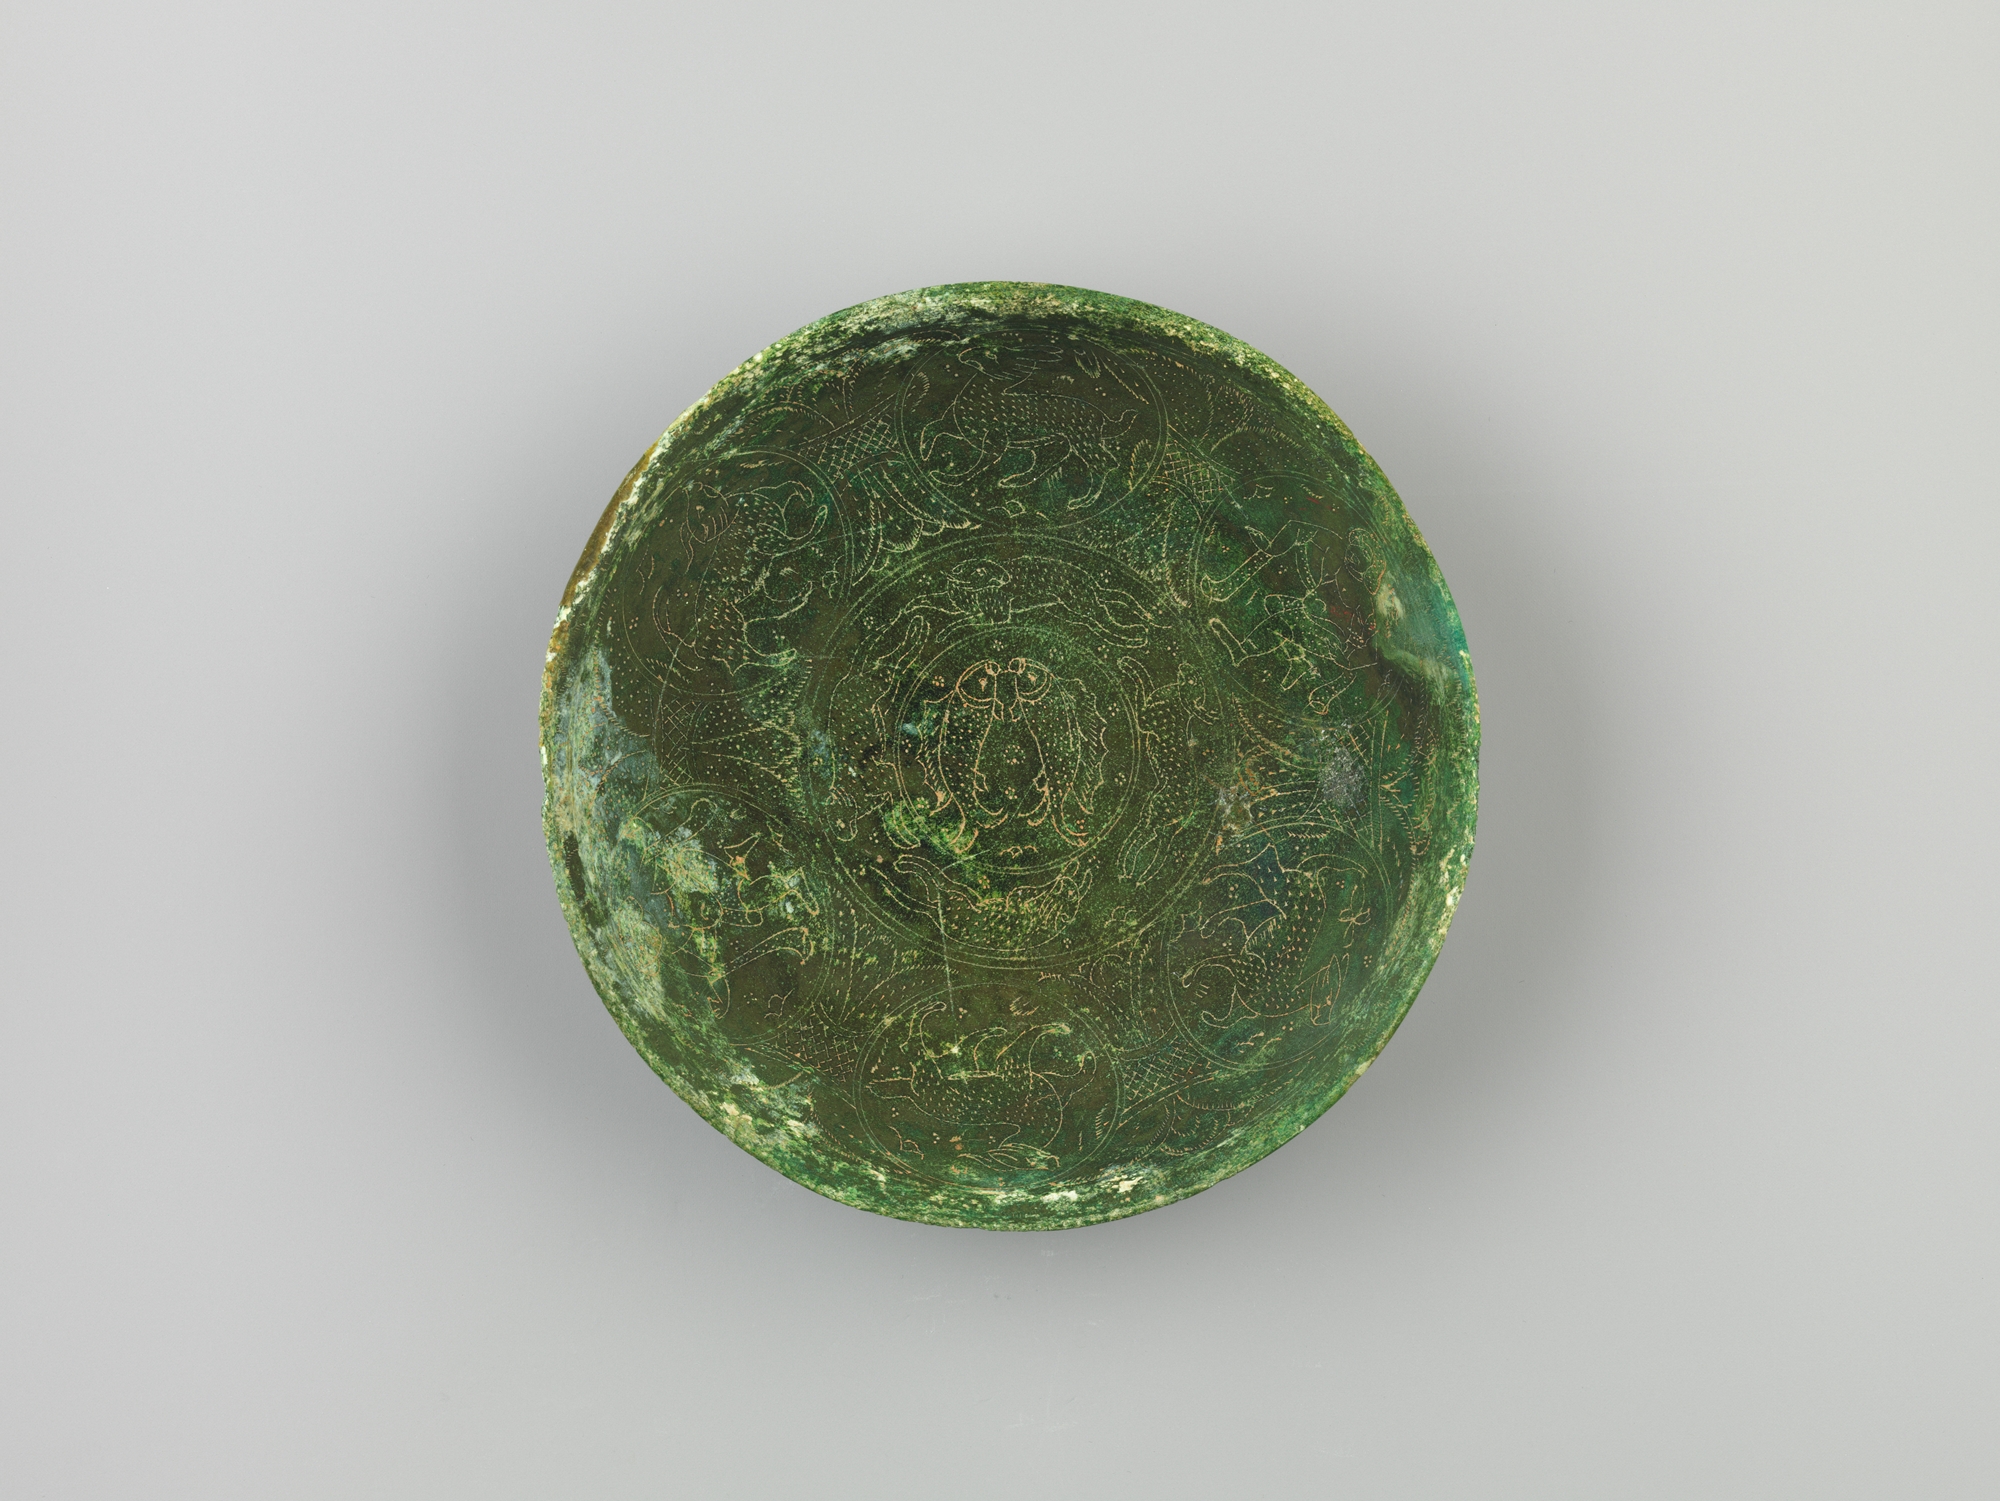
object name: bowl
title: Bowl with double fish, dancers, and animals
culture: chinese or central asian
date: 401-600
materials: bronze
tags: animals,fish,dancers